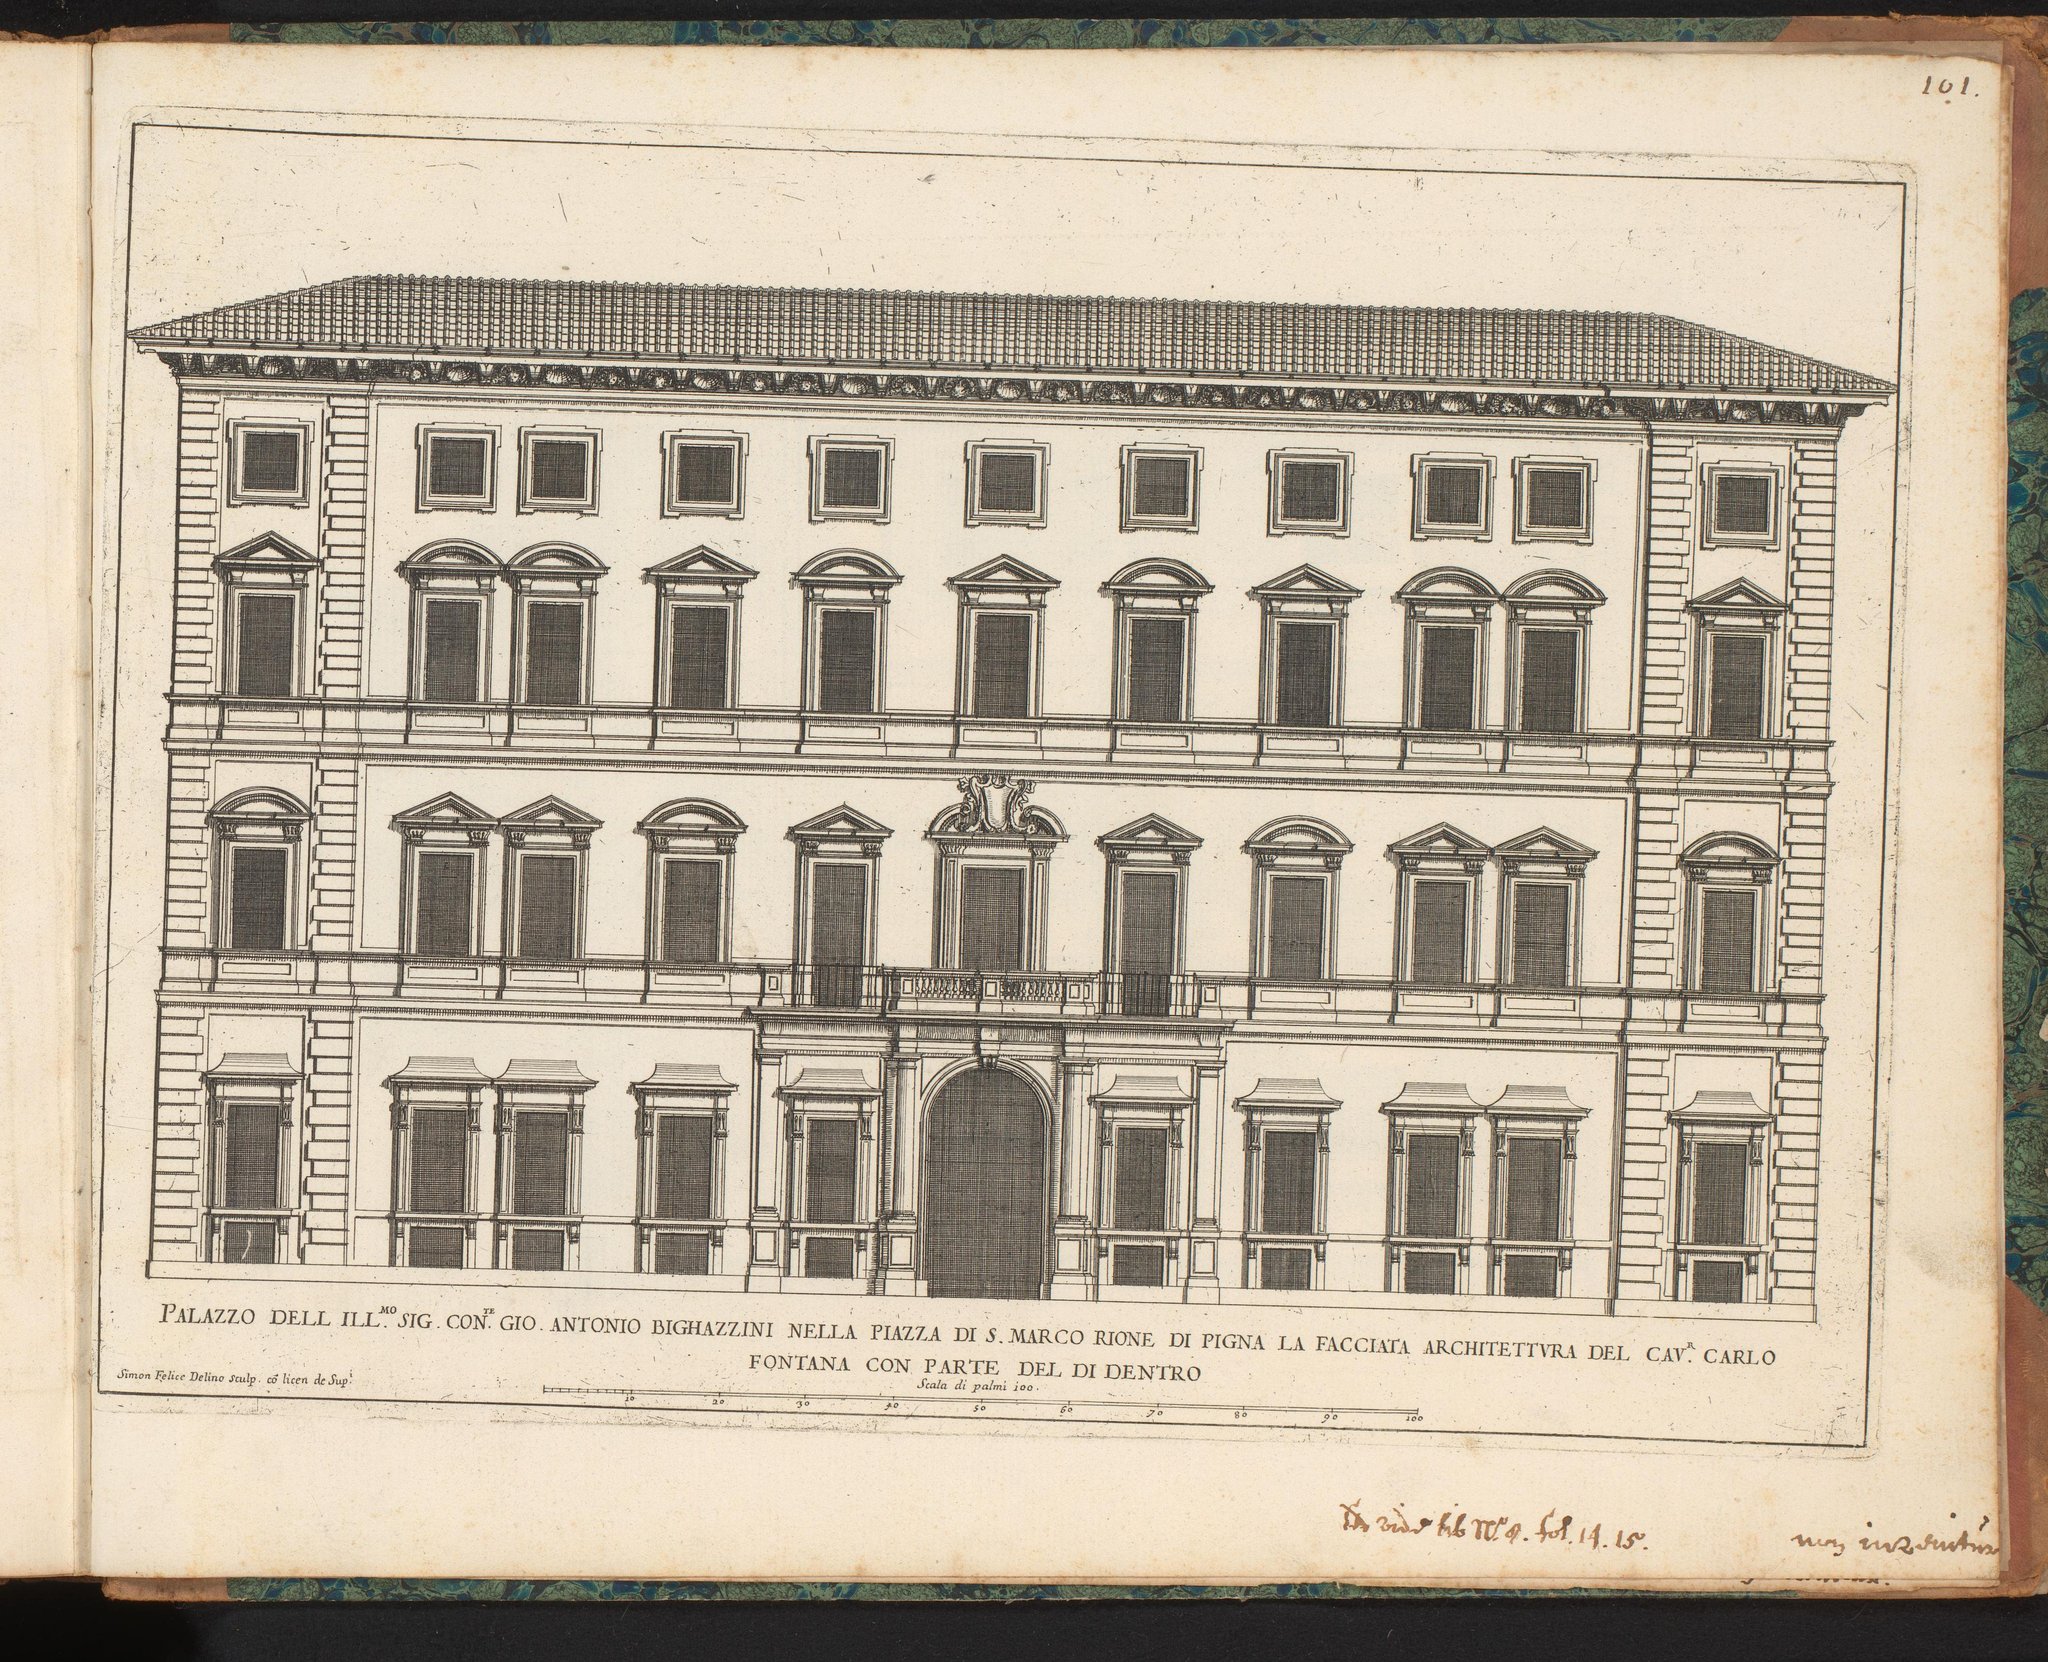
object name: print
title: Façade van Palazzo Bighazzini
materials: paper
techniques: etching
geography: vatican city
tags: palace, façade (of house or building)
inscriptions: inscription: ‘[...] Ende lib. No. 8. fol. 14. 15./ [...]’, number: ‘101’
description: Deze prent maakt deel uit van de reeks getiteld: Palazzi di Roma. Deze reeks bestaat uit twee boeken. Boek één getiteld: Palazzi di Roma dei più celebri architetti..., bestaat uit 44 prenten die worden toegeschreven aan Giovanni Battista Falda (naam staat enkel op prent 27) en uitgegeven door Giovanni Giacomo de'Rossi. Deze 44 prenten zijn bekend in twee staten (met en zonder nummer). Boek twee getiteld: Nuovi disegni dell'architetture... libro secondo, bevat 66 prenten door Giovanni Battista Falda en Simone Felice. Deze 66 prenten zijn bekend in twee staten (met en zonder nummer).